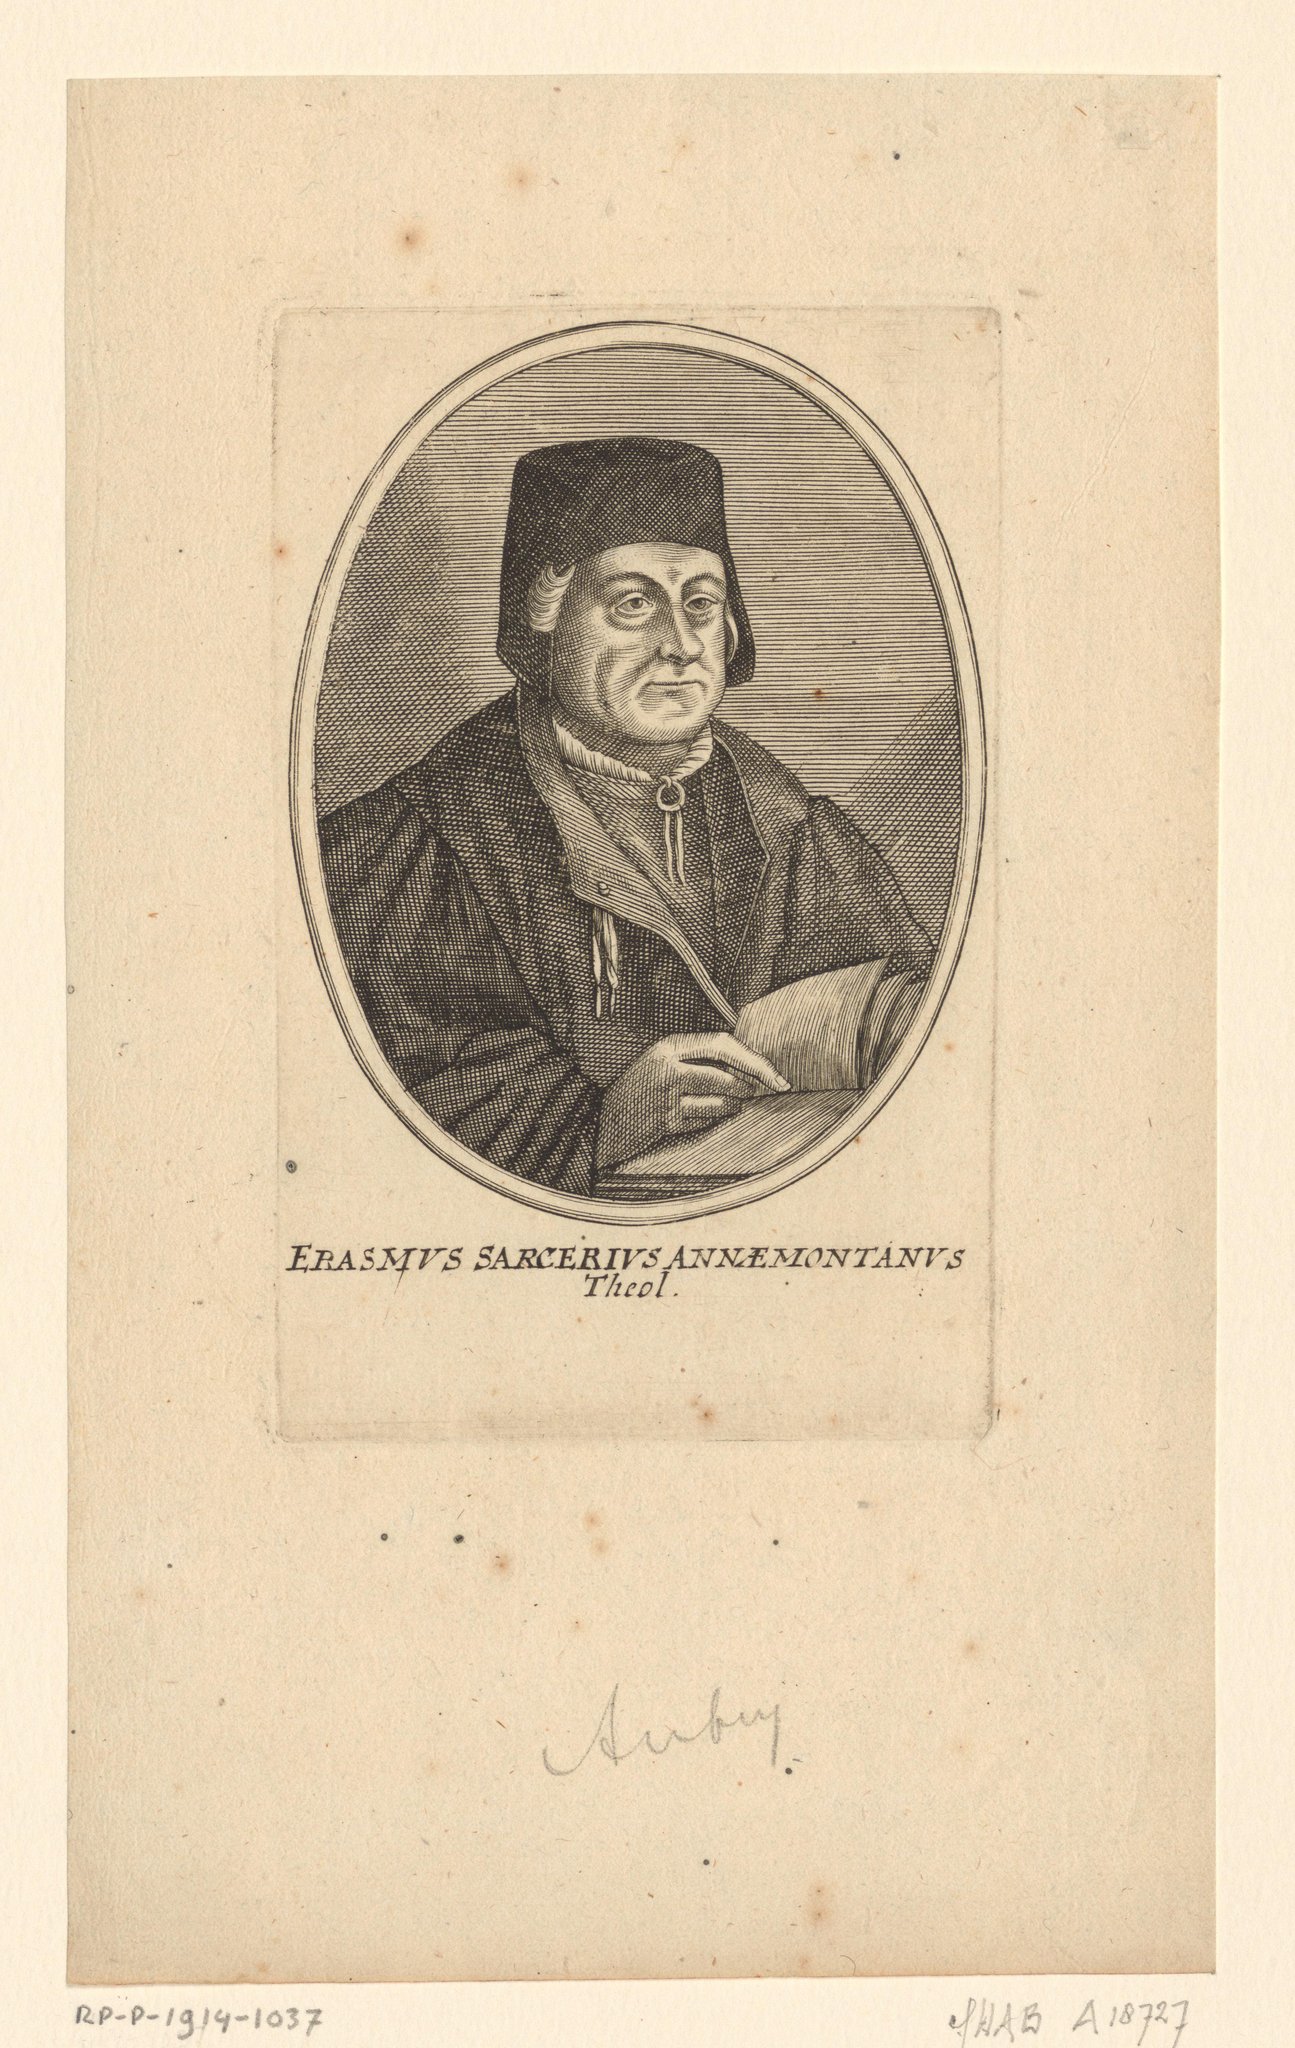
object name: print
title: Portret van Erasmus Sarcerius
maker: Anonymous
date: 1600-1699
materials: paper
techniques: engraving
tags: theologian, historical persons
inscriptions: collector's mark: Lugt 2228